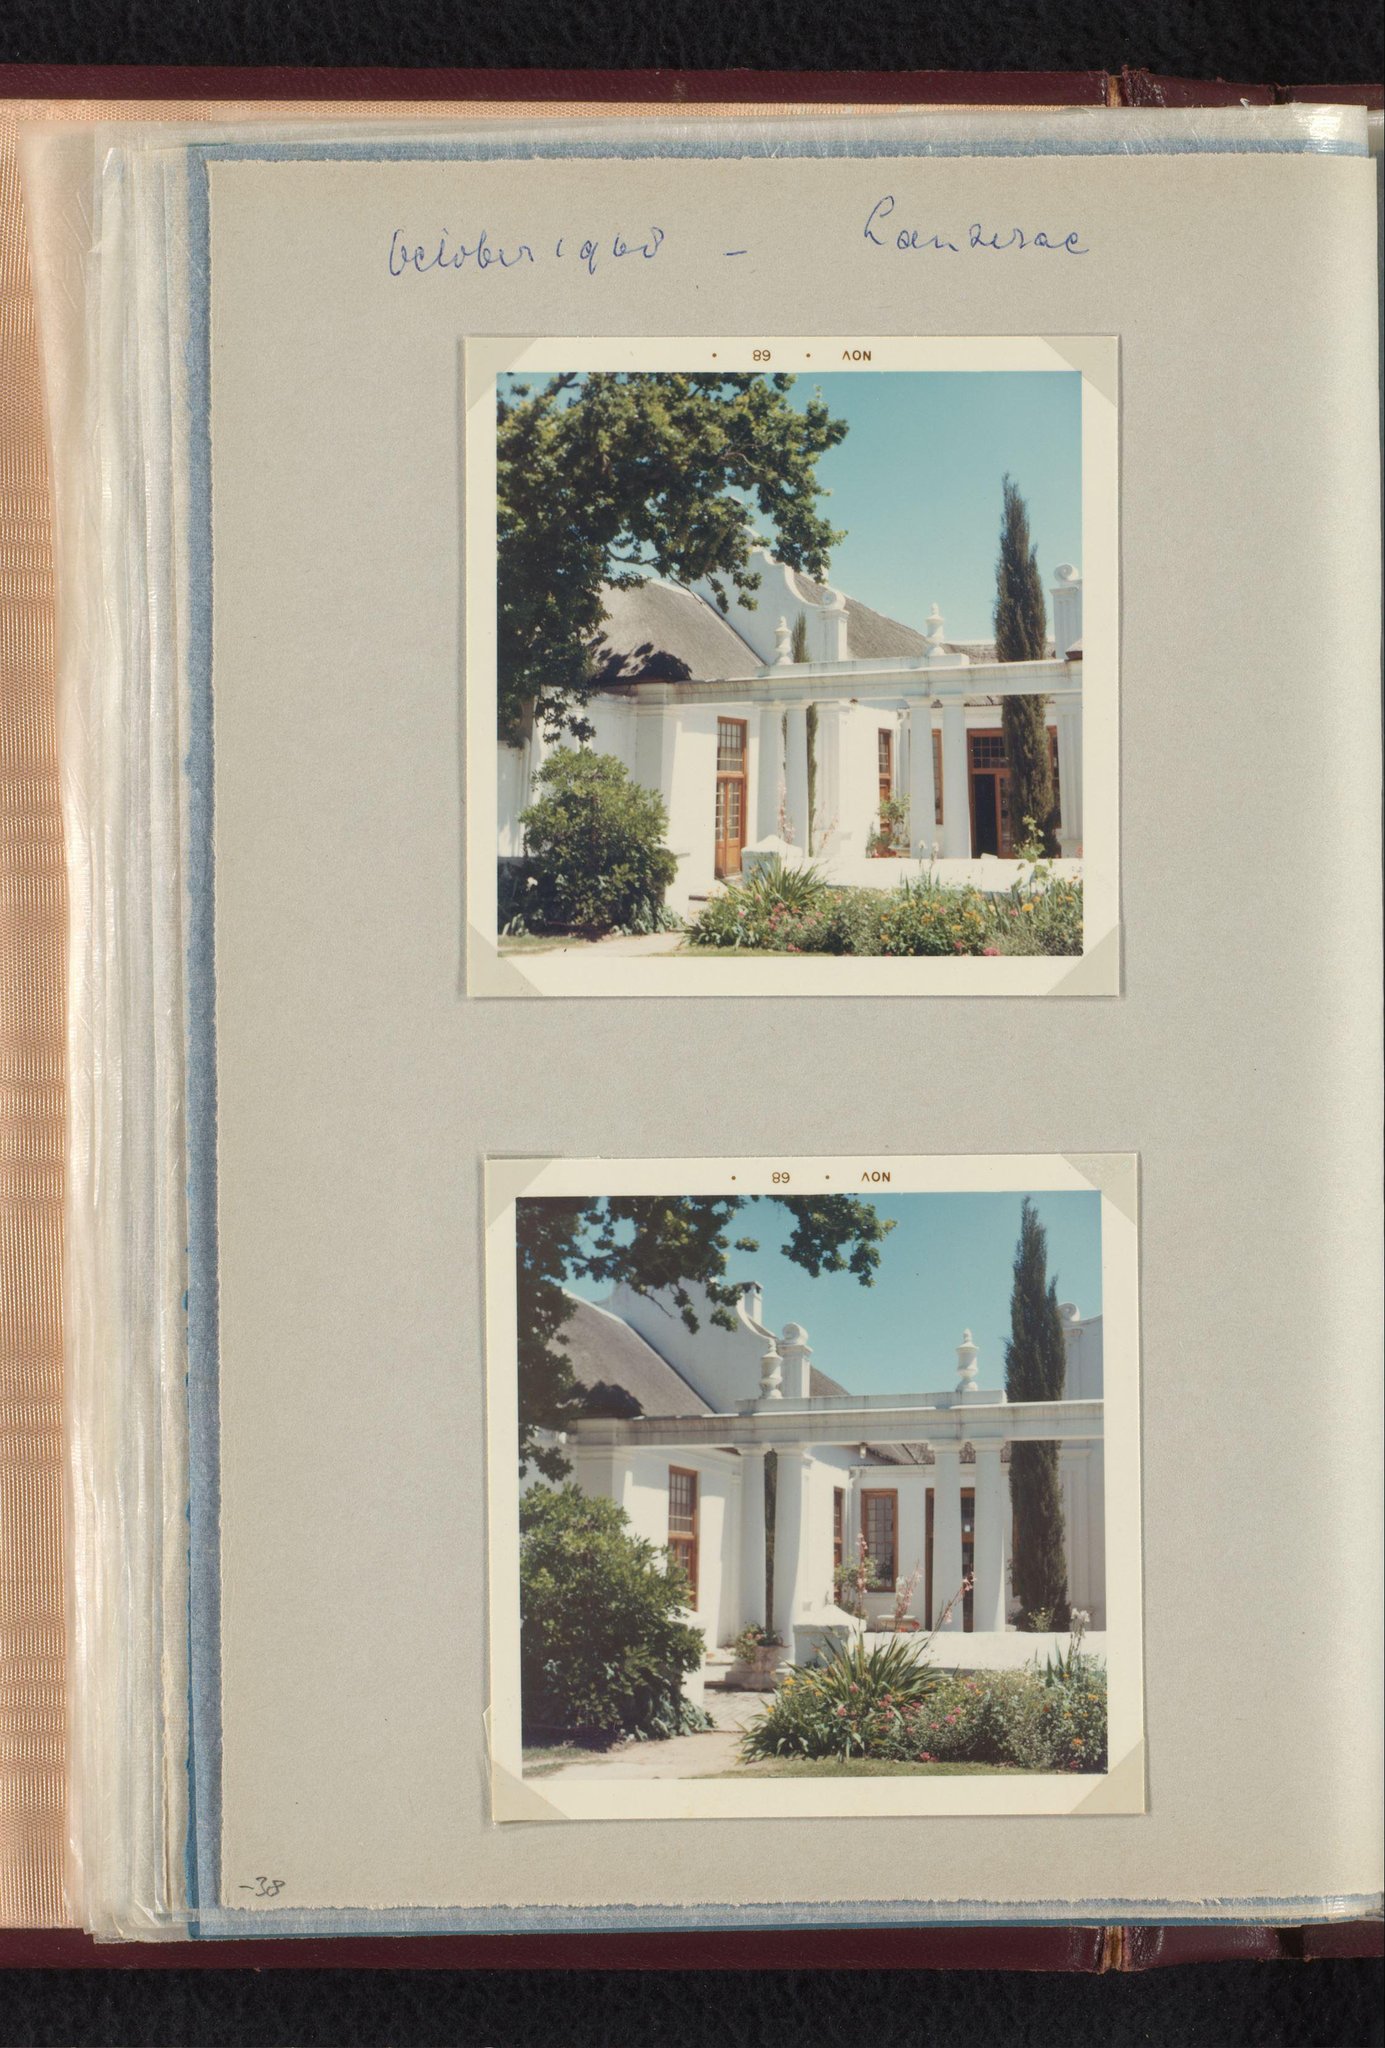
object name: album leaf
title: Wijngaard Lanzerac in Stellenbosch, Zuid-Afrika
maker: willem jacob van den berg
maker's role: boer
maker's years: 1902-1983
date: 1911-1968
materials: paper, cardboard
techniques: chromogenic print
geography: stellenbosch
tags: vineyard, villa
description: Deze foto's zijn onderdeel van een album.